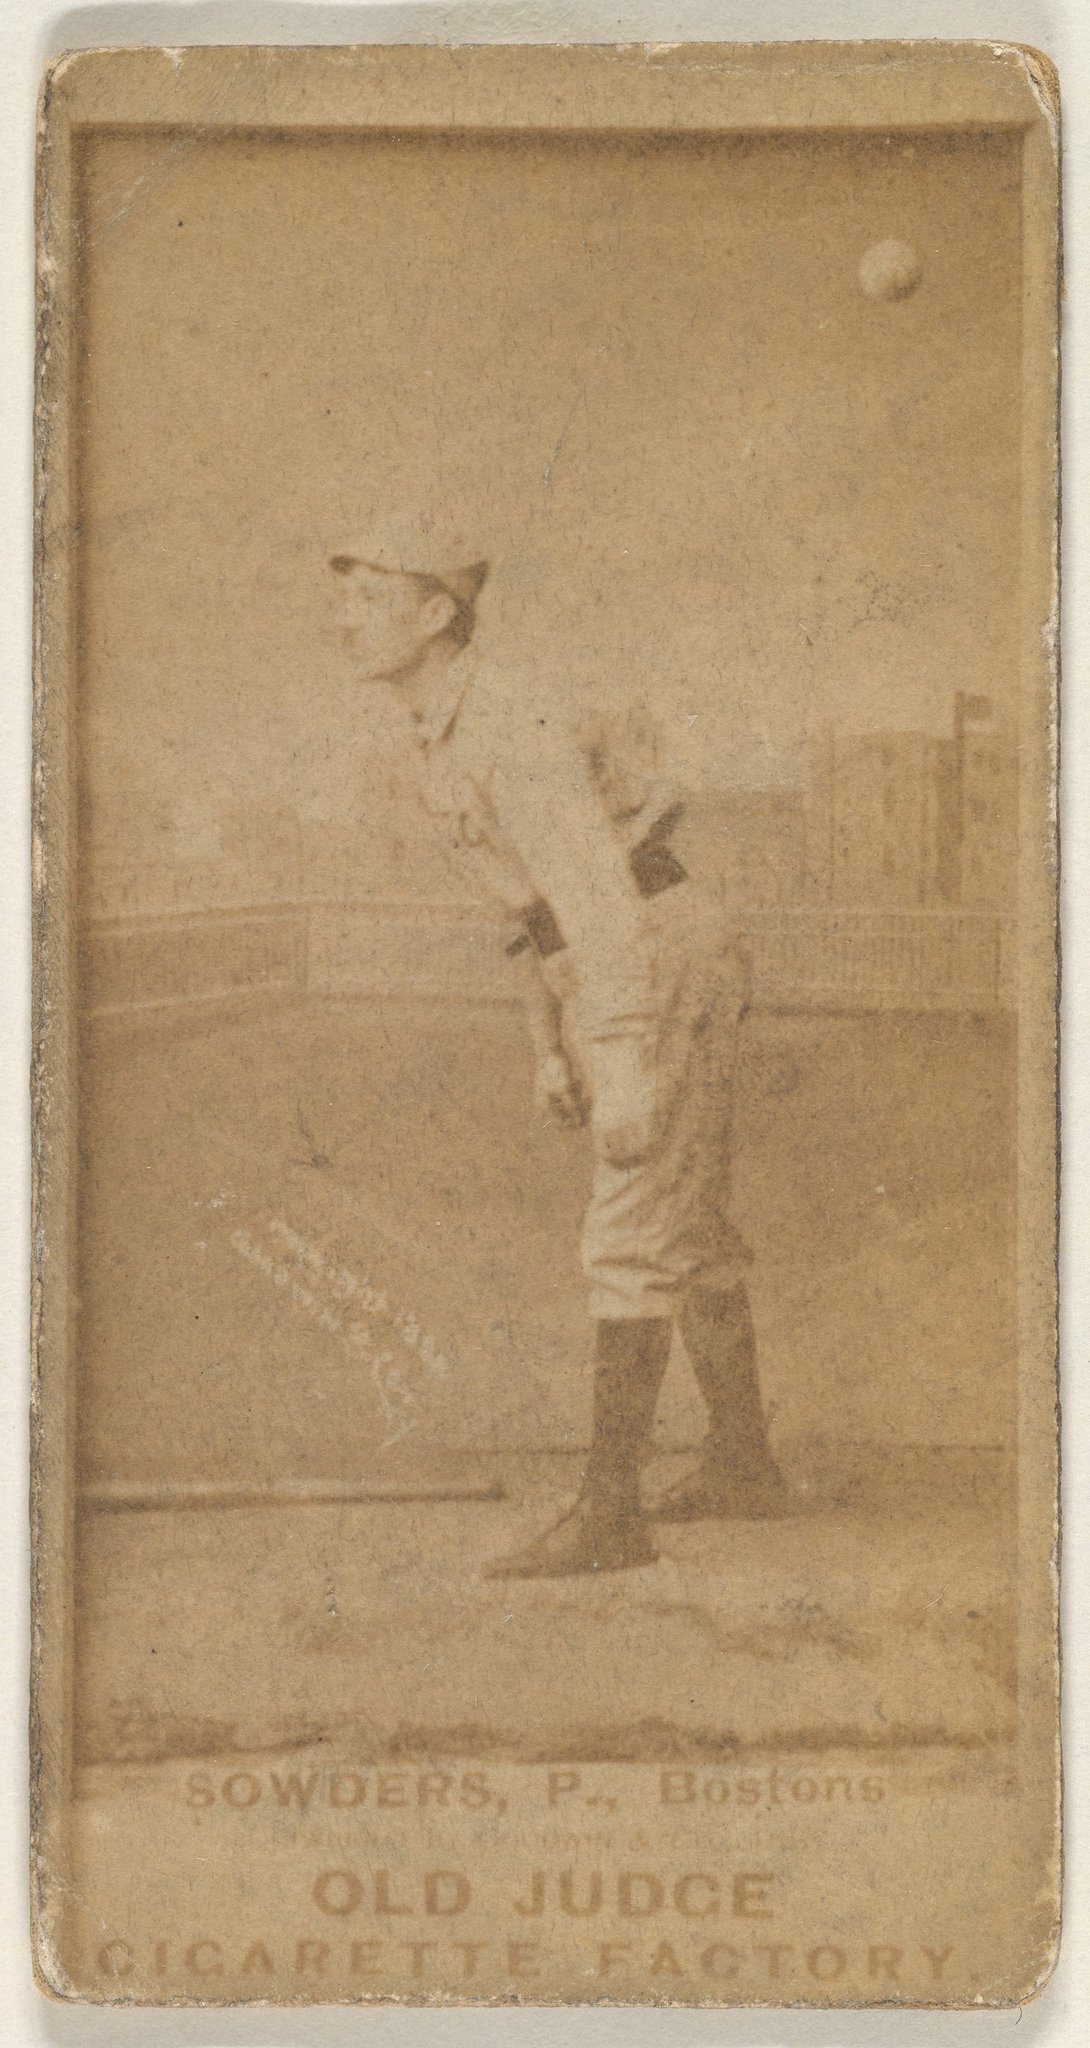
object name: baseball card, photograph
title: Sowders, Pitcher, Boston, from the Old Judge series (N172) for Old Judge Cigarettes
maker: goodwin & company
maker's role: publisher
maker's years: 1850-1950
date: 1887-1890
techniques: albumen silver print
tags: men,portraits,baseball,athletes